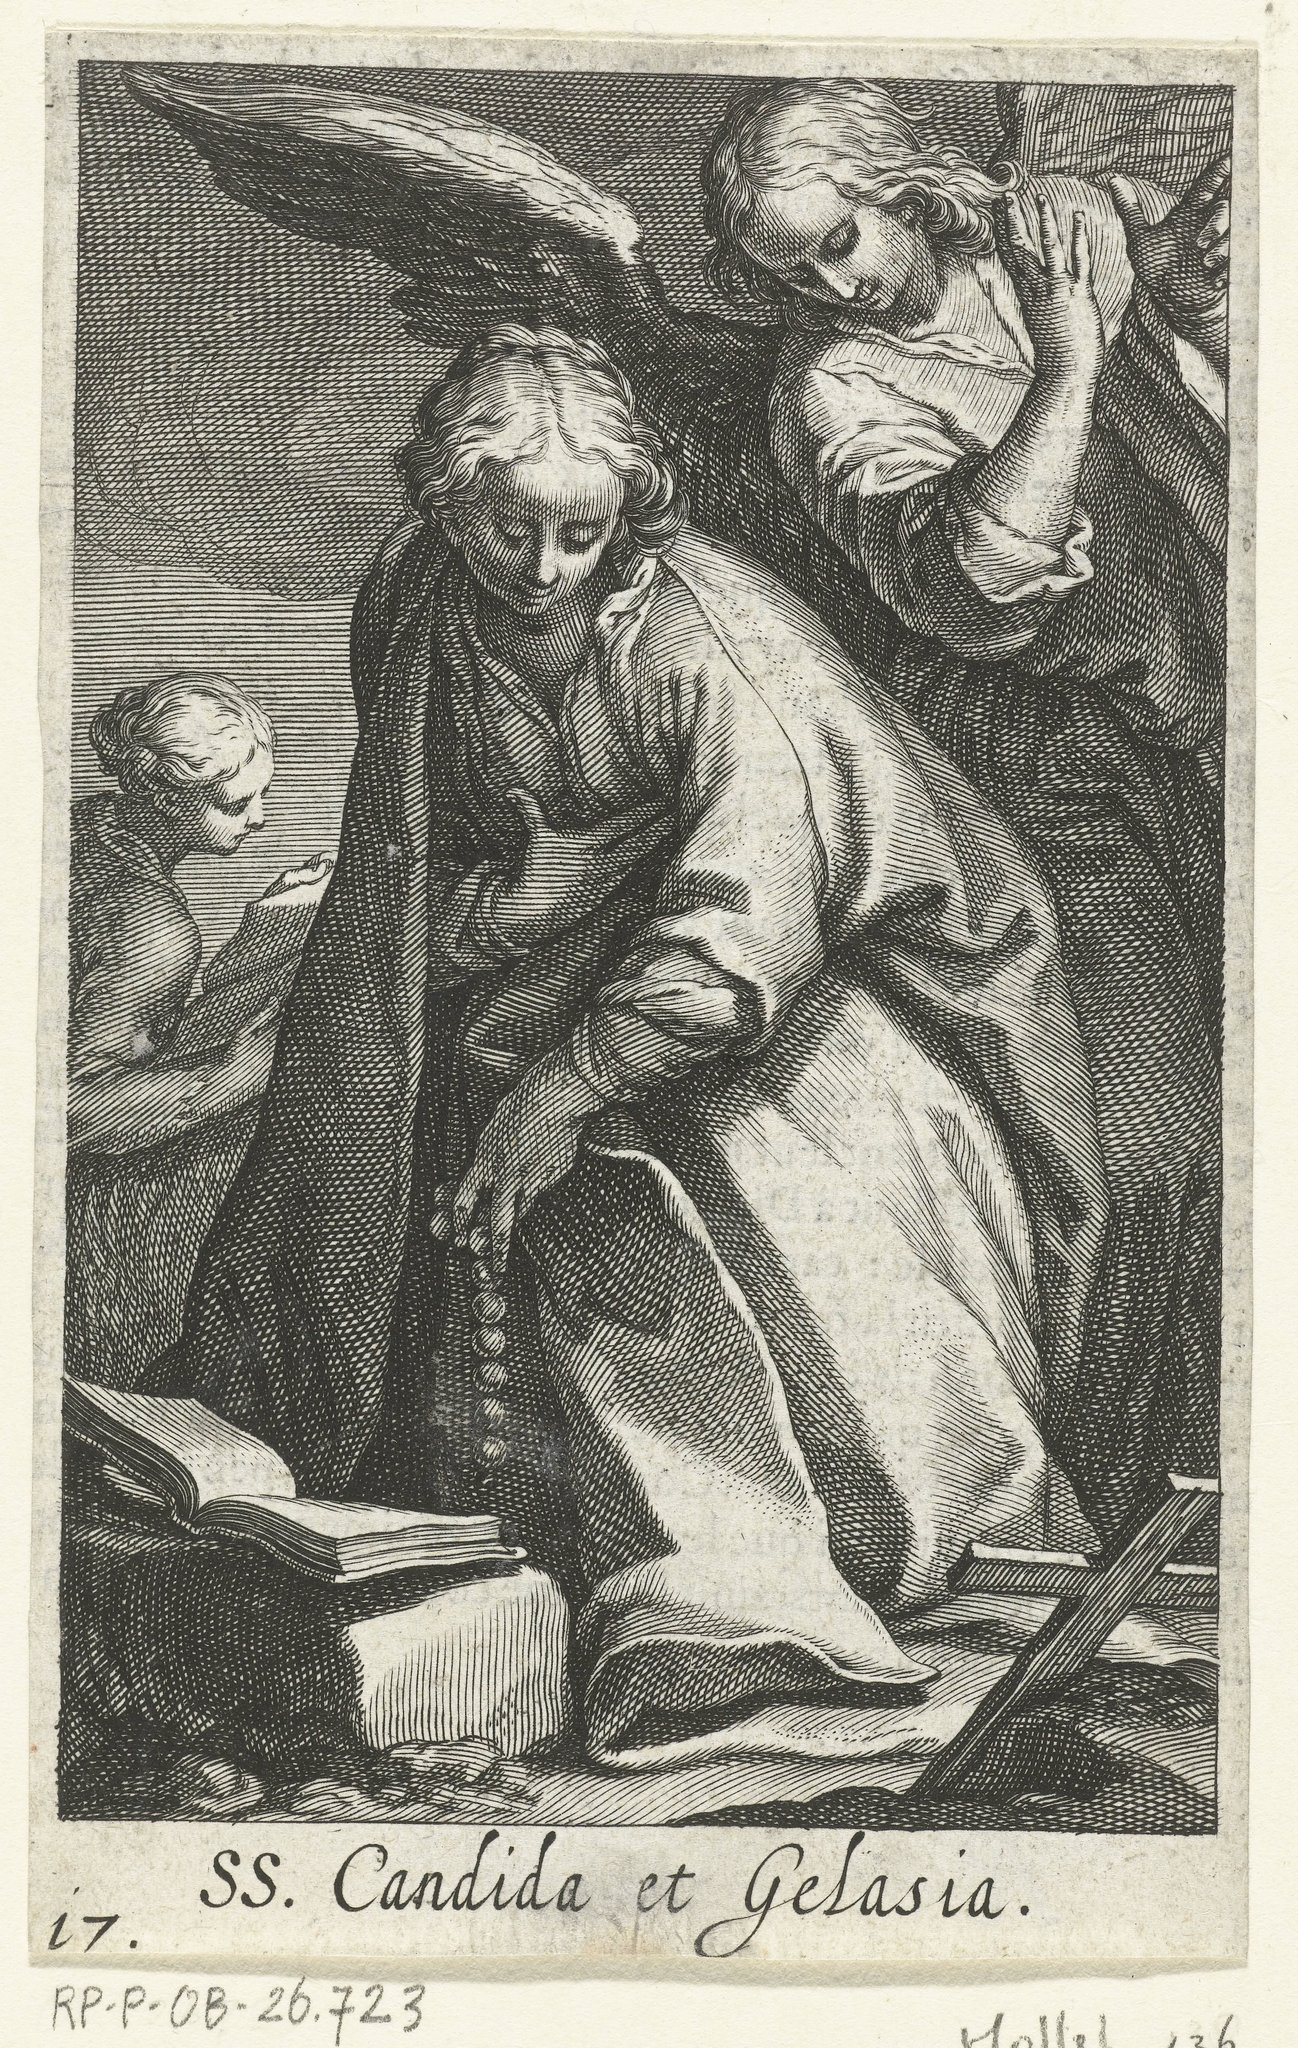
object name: print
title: SS. Candida et Gelasia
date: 1590-1612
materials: paper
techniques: engraving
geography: low countries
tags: anchorite, hermit, female saints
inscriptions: collector's mark: Lugt 2228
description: Prent uit: Sacra Eremus Ascetriarum, Hendrik Aertssen, Antwerpen 1619. Prent uit de serie van vijfentwintig kluizenaressen in deze uitgave. In 1612 verscheen de ongebonden editie maar op basis van de gewijzigde opschriften en samenstelling van de serie kluizenaars wordt aangenomen dat de prenten van de uitgave 1619 ook in 1612 of iets daarvoor gedrukt werden. De serie kluizenaressen bleef vrijwel ongewijzigd in de ongebonden uitgave van 1612, dit compliceert de datering van de losse bladen in de collectie van het RMA, zie Roethlisberger 1993, p. 171-175. Door de aanwezigheid van Franse tekst op het verso kunnen we vaststellen dat dit blad afkomstig is uit de Antwerpse uitgave van 1619.